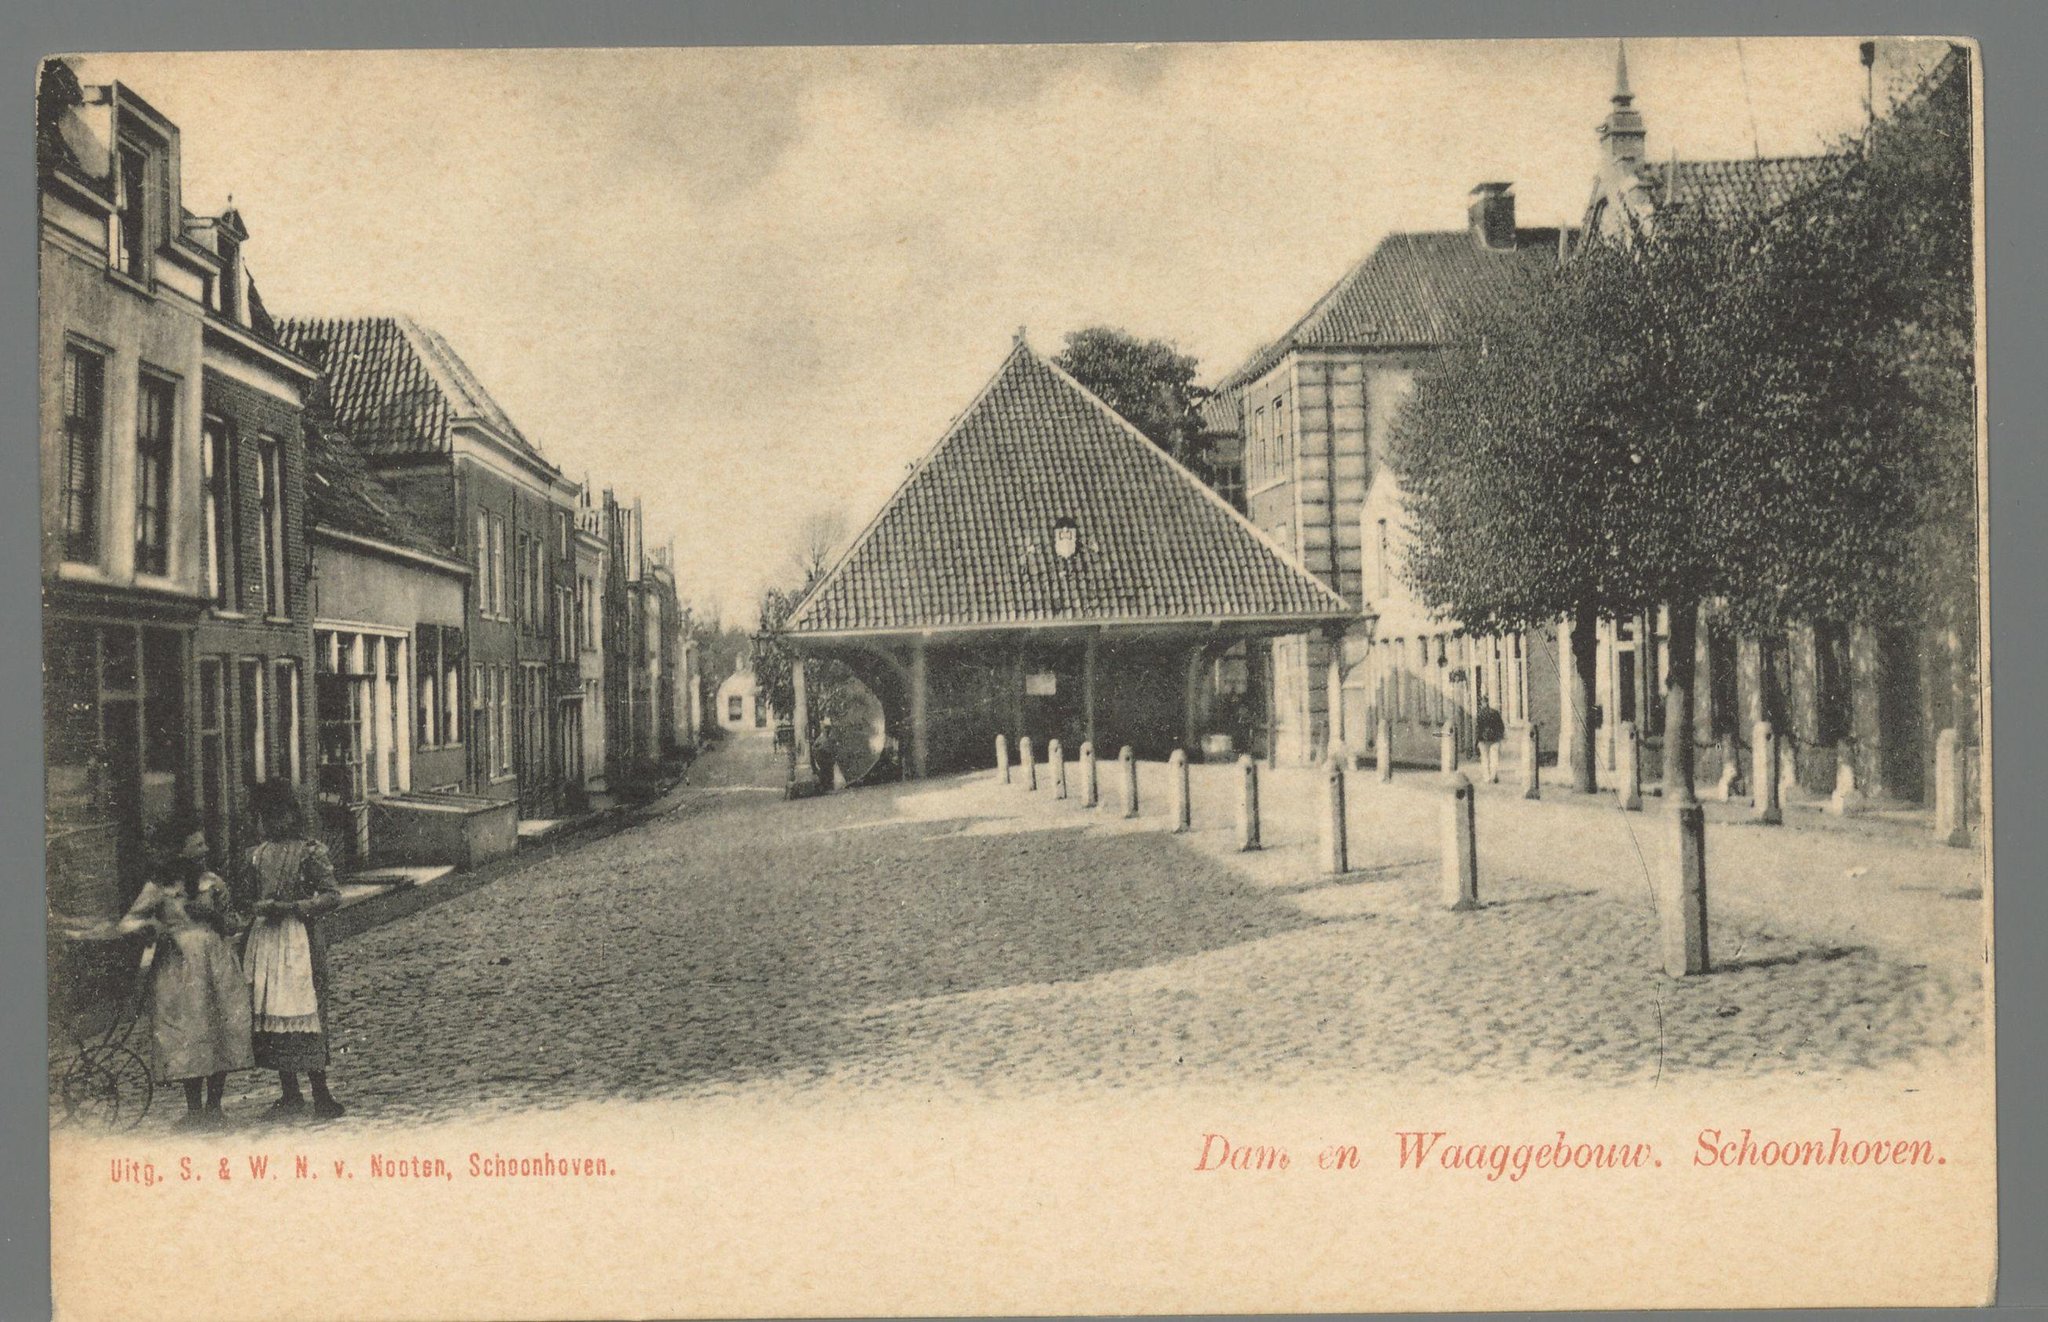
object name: photomechanical print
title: Dam en Waaggebouw. Schoonhoven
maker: Anonymous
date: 1897-1905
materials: cardboard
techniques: photograph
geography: schoonhoven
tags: street, weigh-house